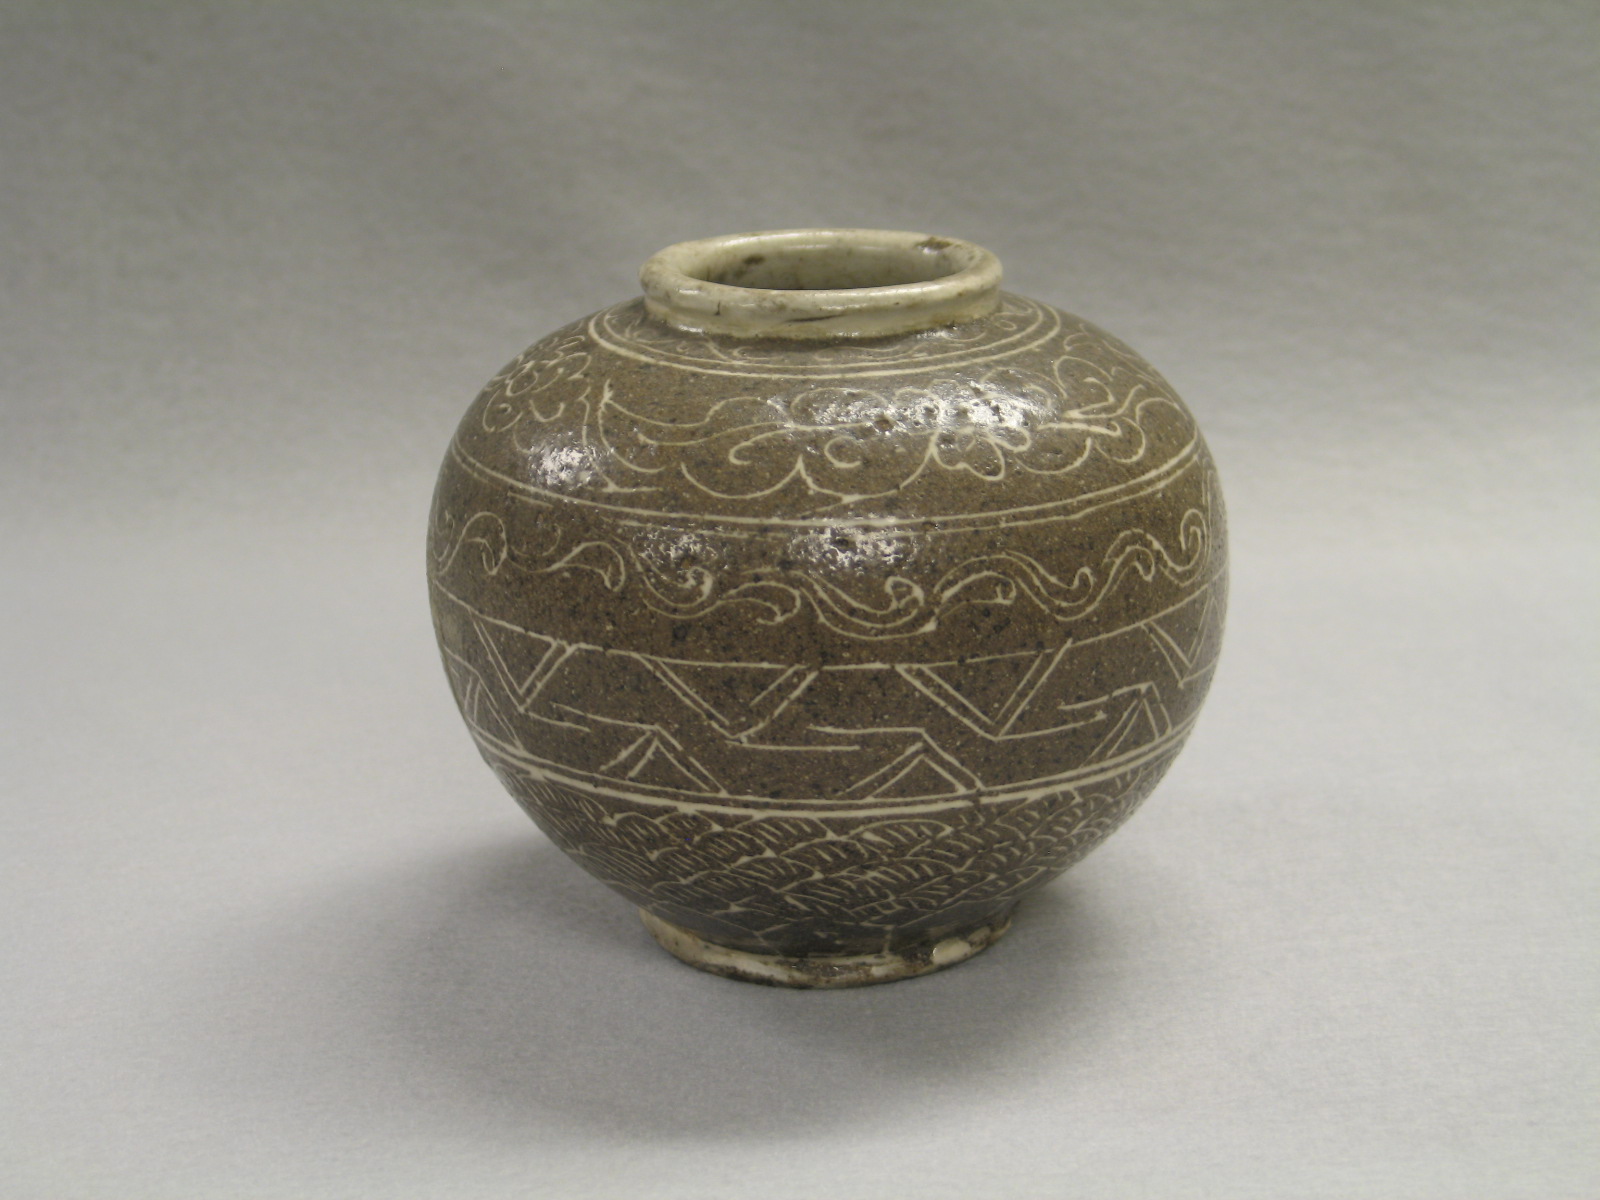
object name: vase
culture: chinese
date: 960-1279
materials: pottery